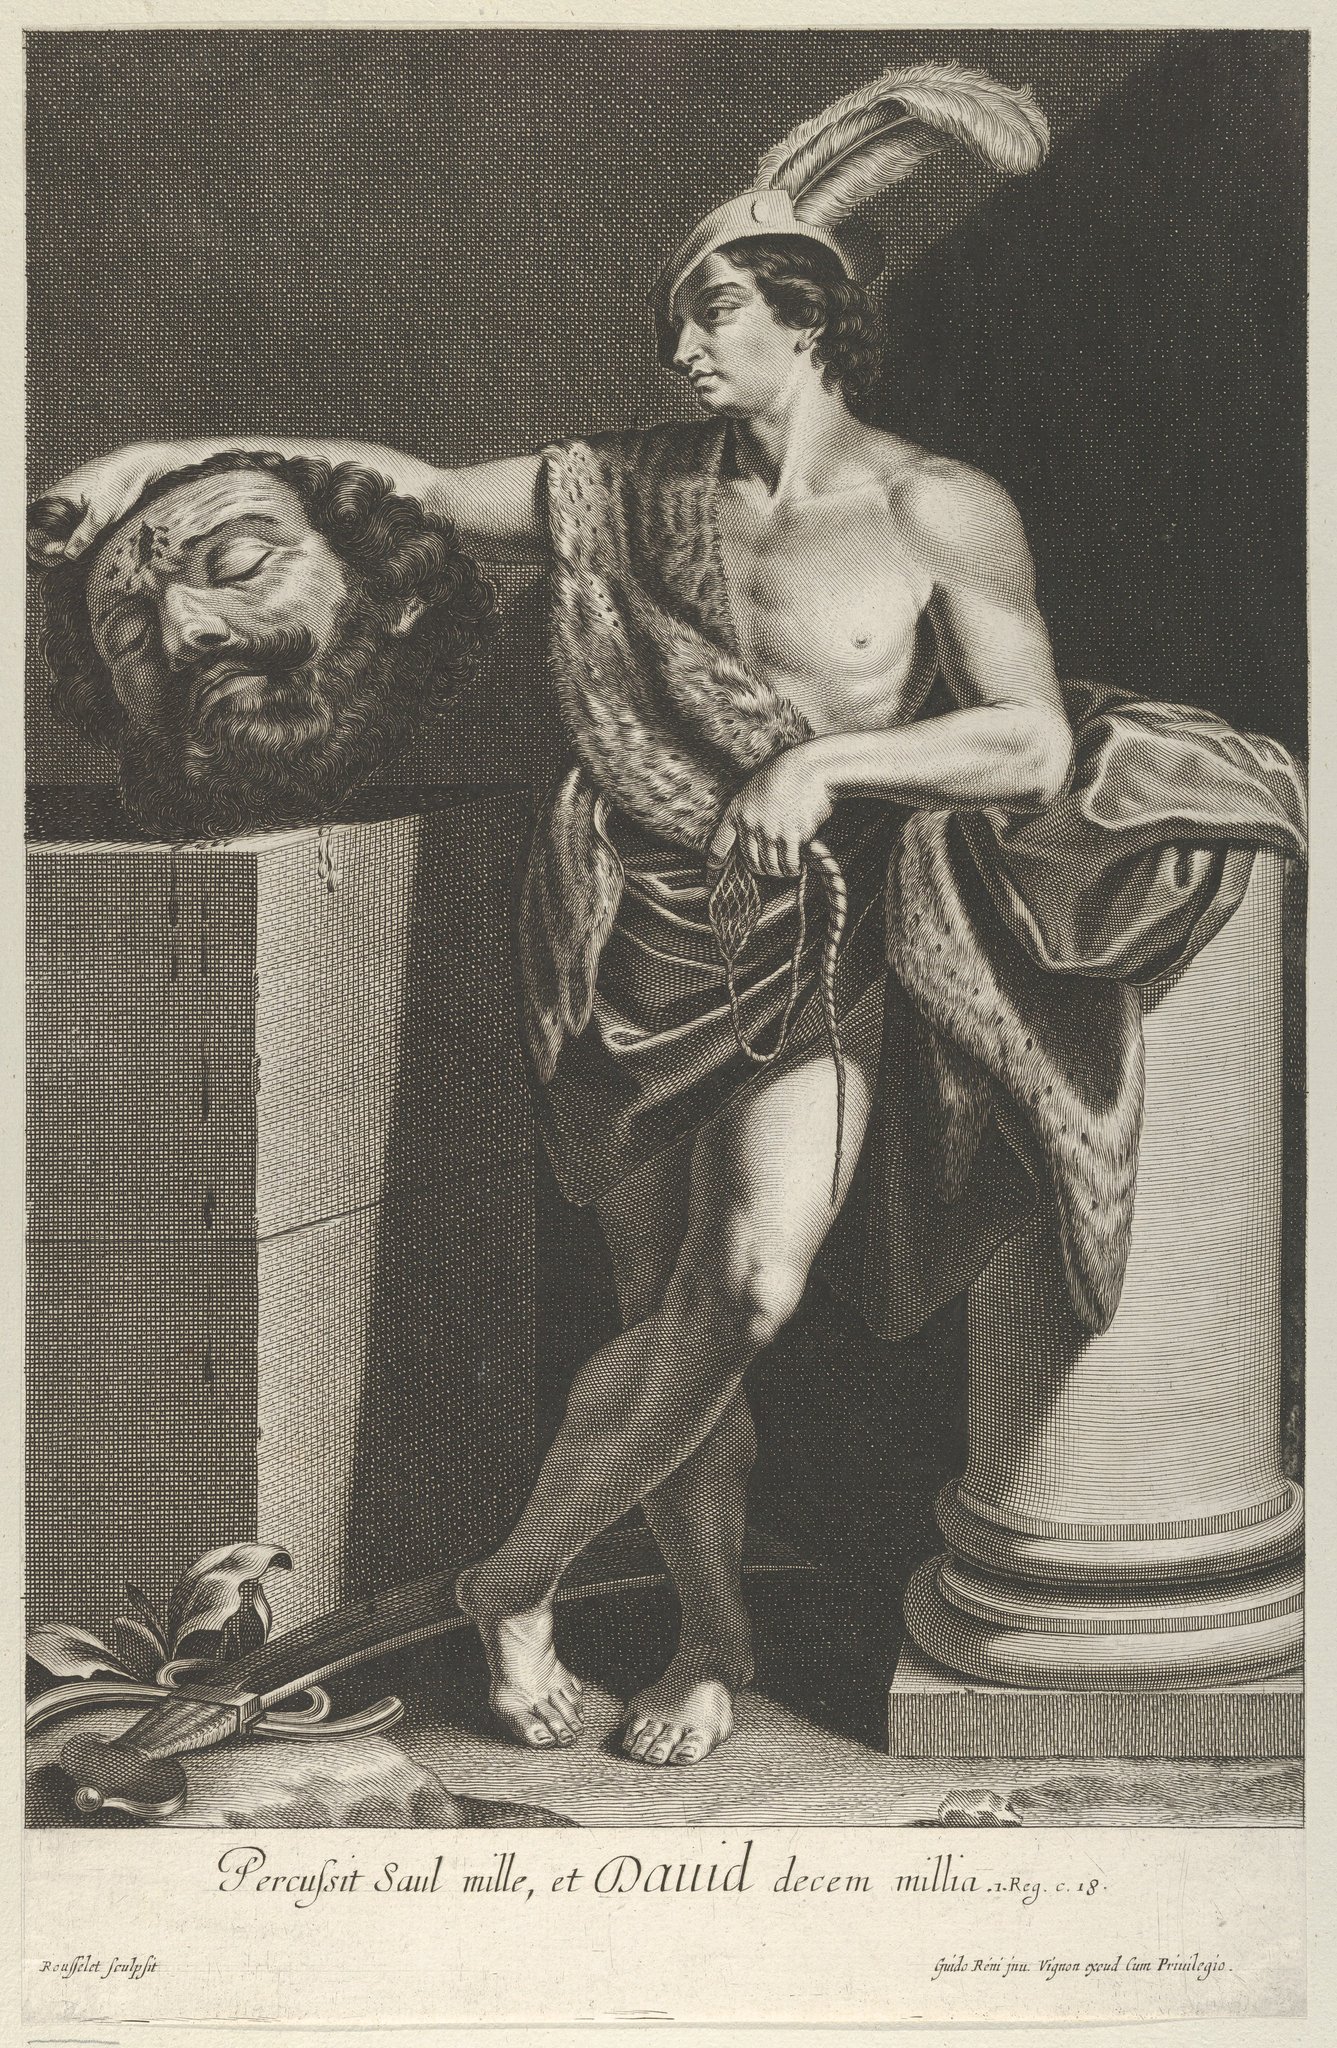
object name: print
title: David standing with crossed legs and holding the head of Goliath on a pedestal at left, a sword on the ground, after Reni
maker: gilles rousselet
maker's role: artist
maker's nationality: french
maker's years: 1614-1686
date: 1635-1645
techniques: engraving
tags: swords,heads,david